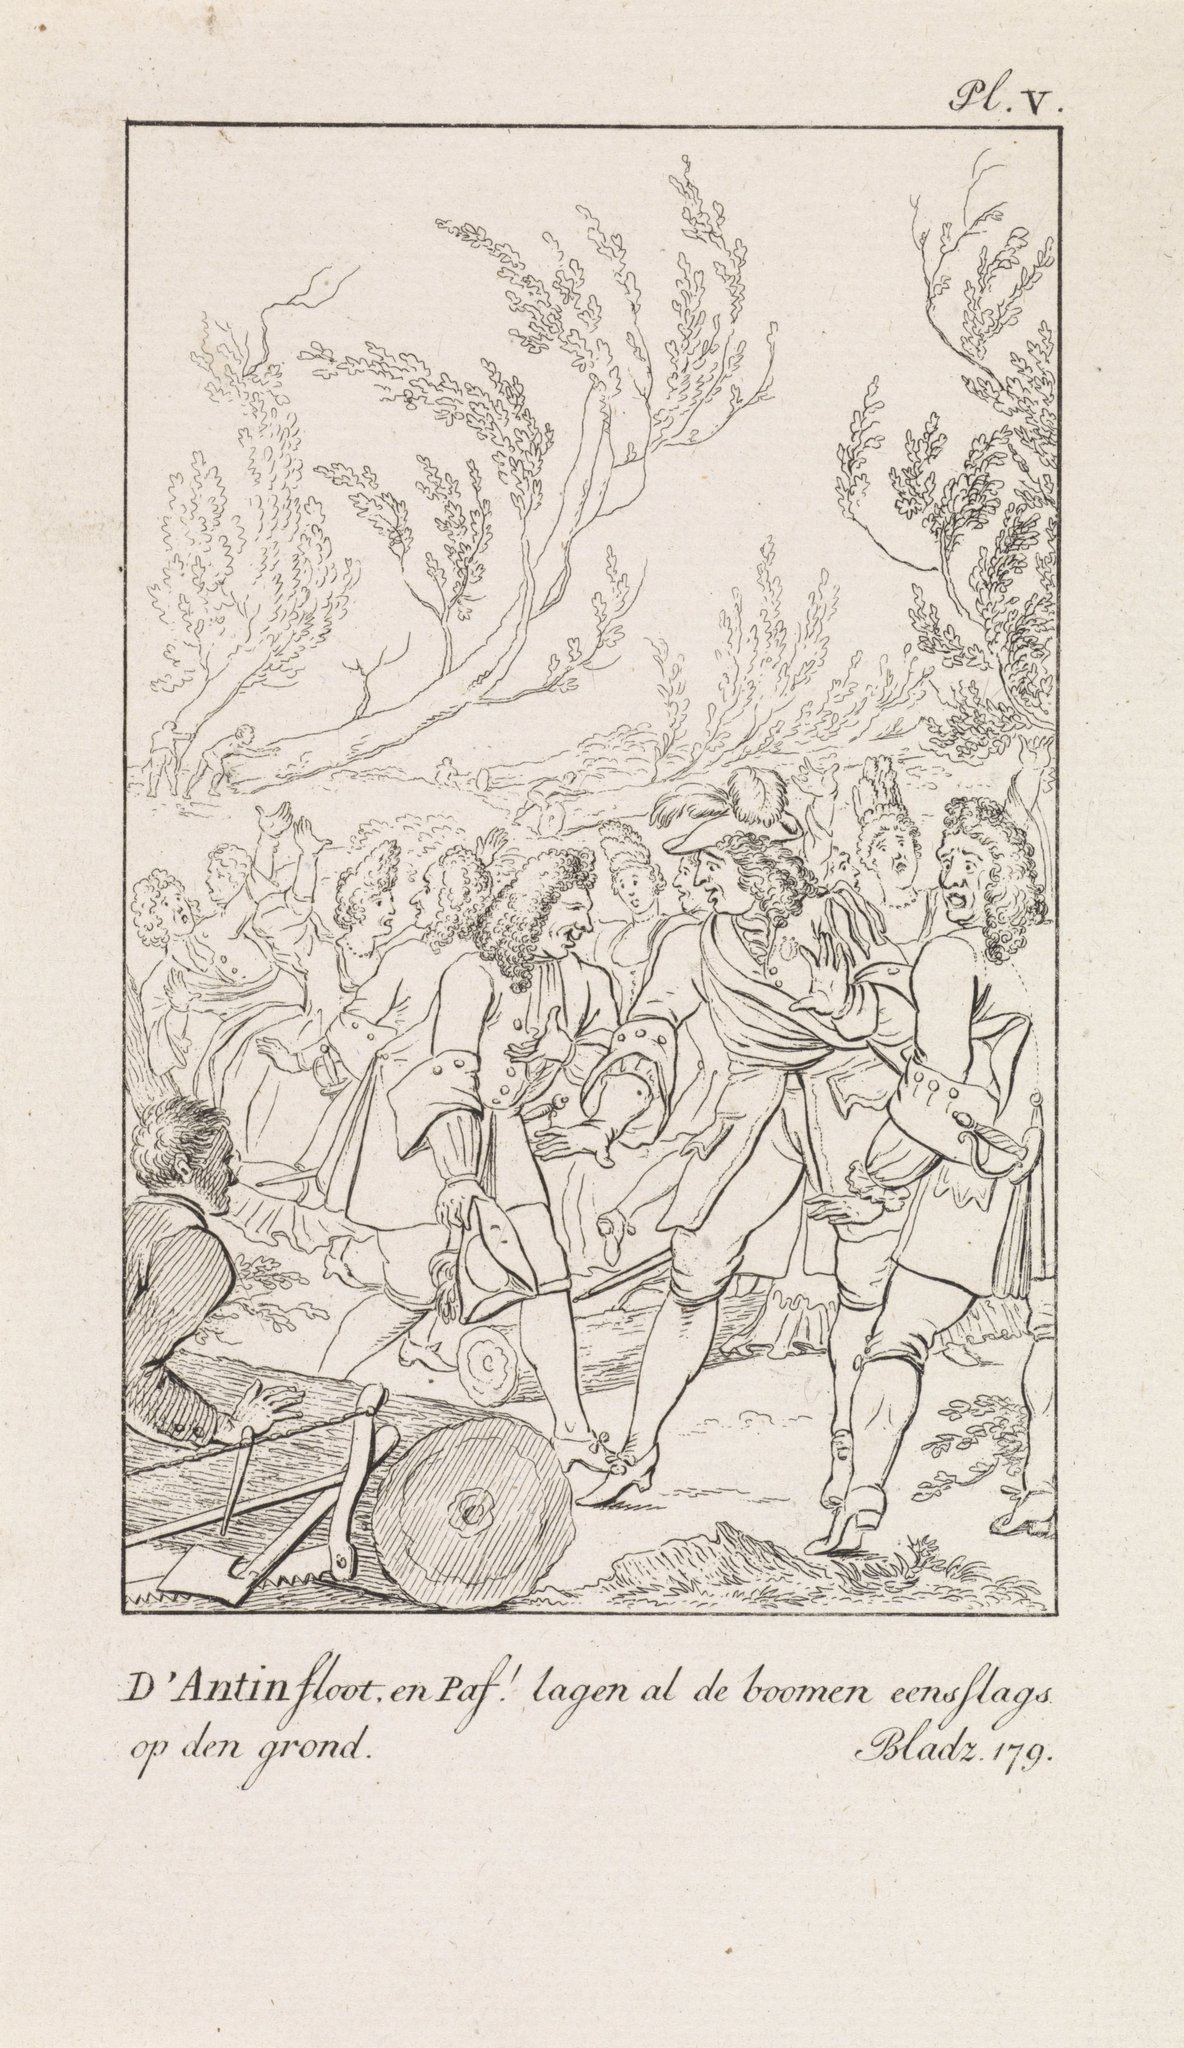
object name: book illustration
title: Gezelschap in een bos bij omgehakte bomen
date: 1802-1809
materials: paper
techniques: etching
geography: haarlem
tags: trees, political caricatures and satires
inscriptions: collector's mark: Lugt 2228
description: Een gezelschap van heren en dames in een bos. Op de achtergrond figuren bij omgehakte bomen en links op de voorgrond een man met een zaag en een bijl bij een liggende boomstam. Rechtsboven: Pl. V. Rechtsonder: Bladz. 179.